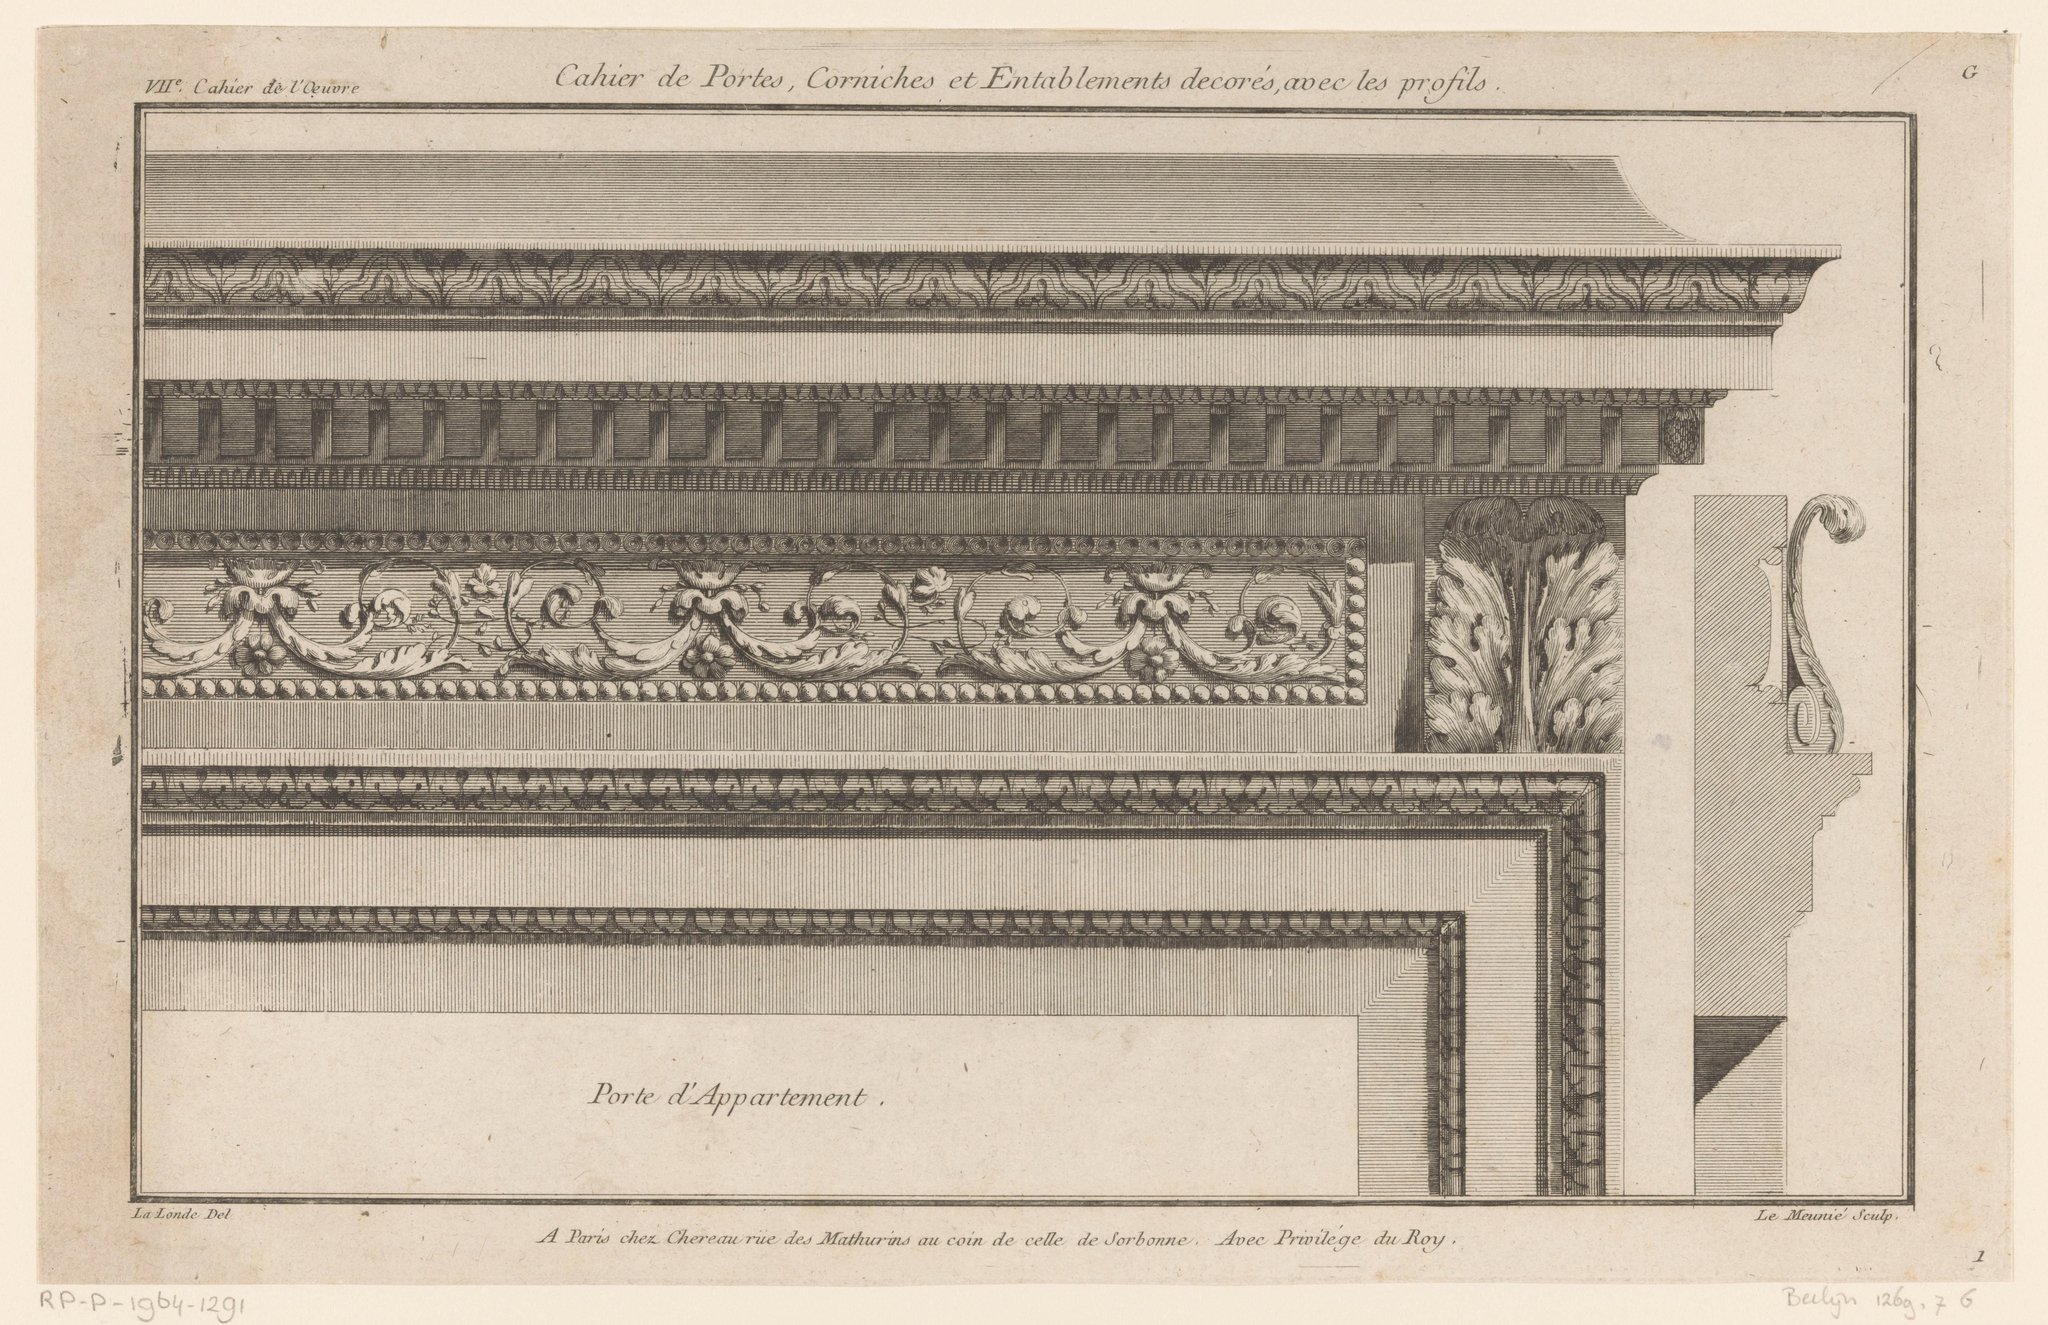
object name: print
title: VIIe Cahier de l'Oeuvre G Cahier de Portes, Corniches et Entablements decorés, aves les profils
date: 1784-1785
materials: paper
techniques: engraving, etching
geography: paris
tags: ornaments ~ art (+ framing decorations), door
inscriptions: collector's mark: Lugt 2760, collector's mark: Lugt 2228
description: Vooraanzicht en profiel van een geornamenteerde deurlijst met vlechtwerk en acanthusbladeren.